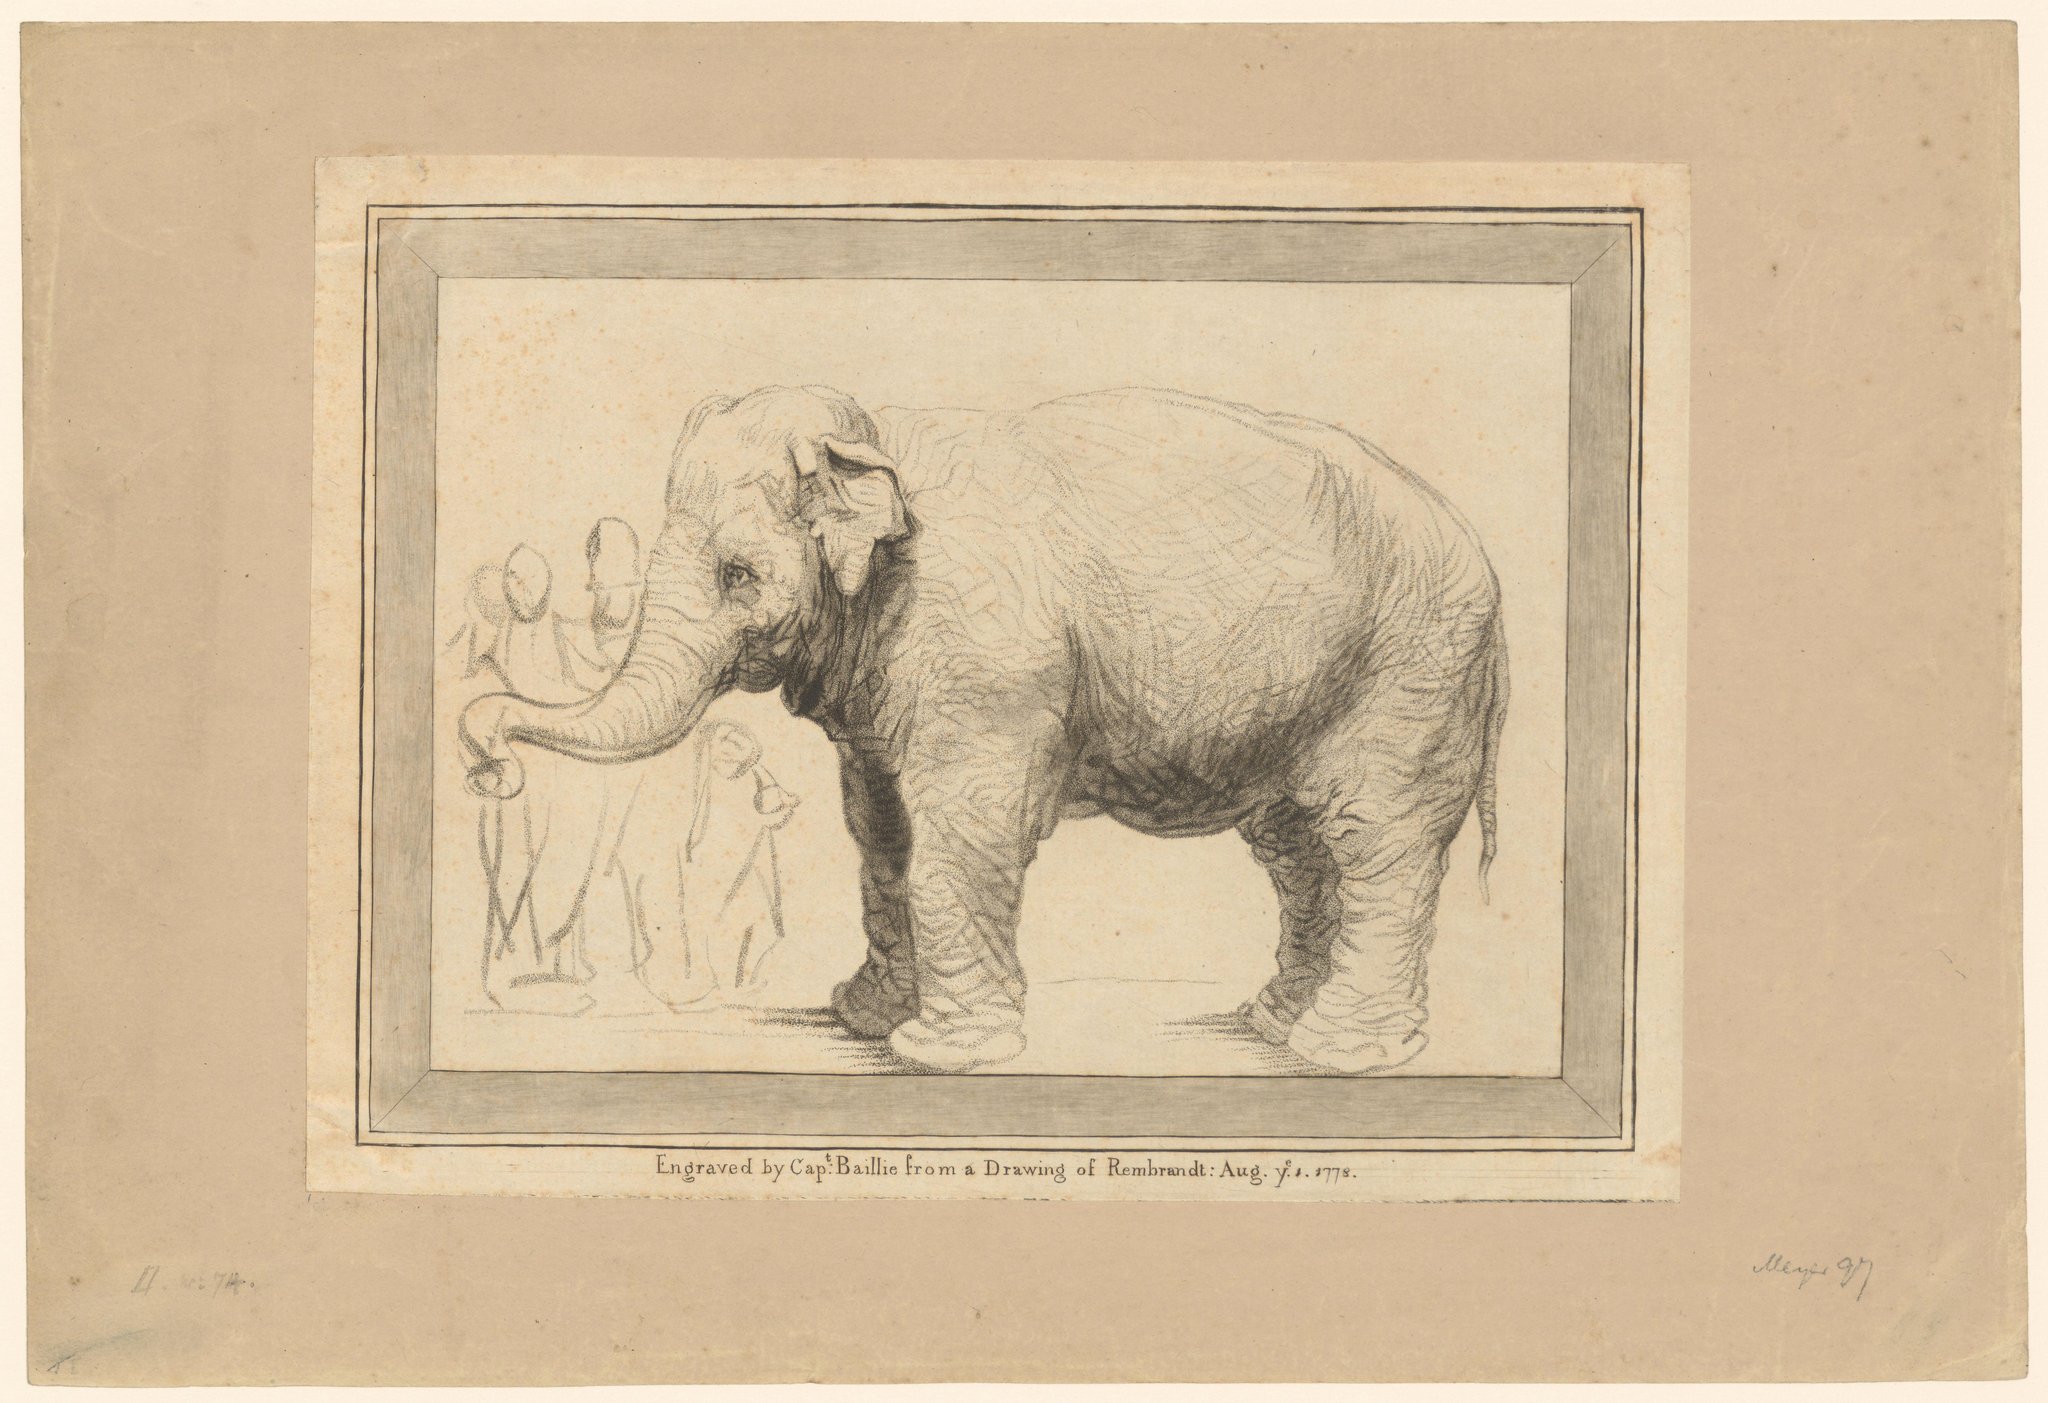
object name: print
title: Olifant met omstanders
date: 1778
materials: paper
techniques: printmaking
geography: england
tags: trunked animals: elephant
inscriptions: date